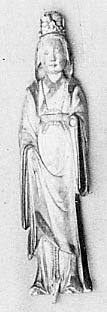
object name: figure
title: Carved Figure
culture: chinese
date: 1401-1500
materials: ivory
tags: human figures